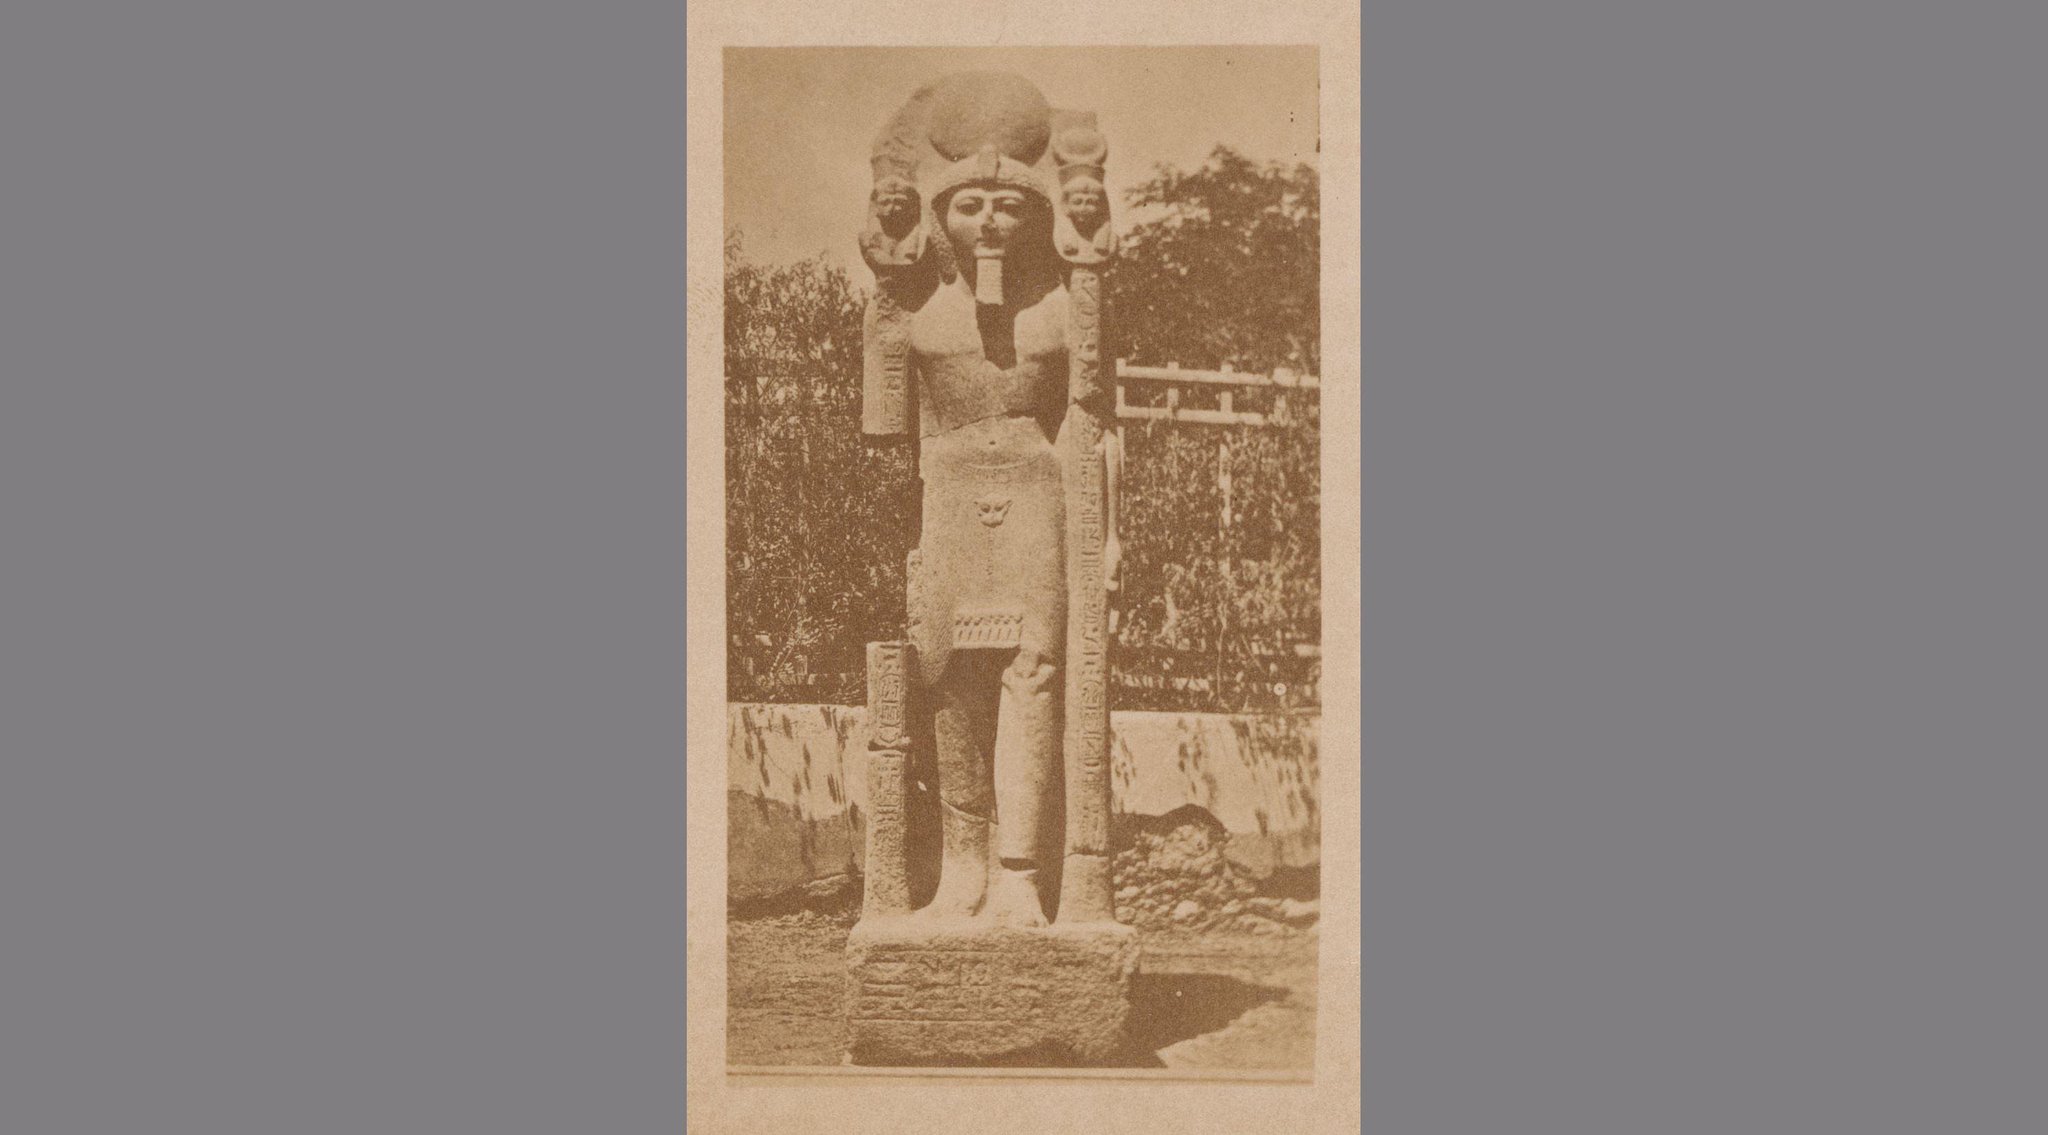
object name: photograph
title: Egyptische sculptuur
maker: Anonymous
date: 1870-1890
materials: paper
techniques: albumen print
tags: piece of sculpture, reproduction of a piece of sculpture, egyptian religion